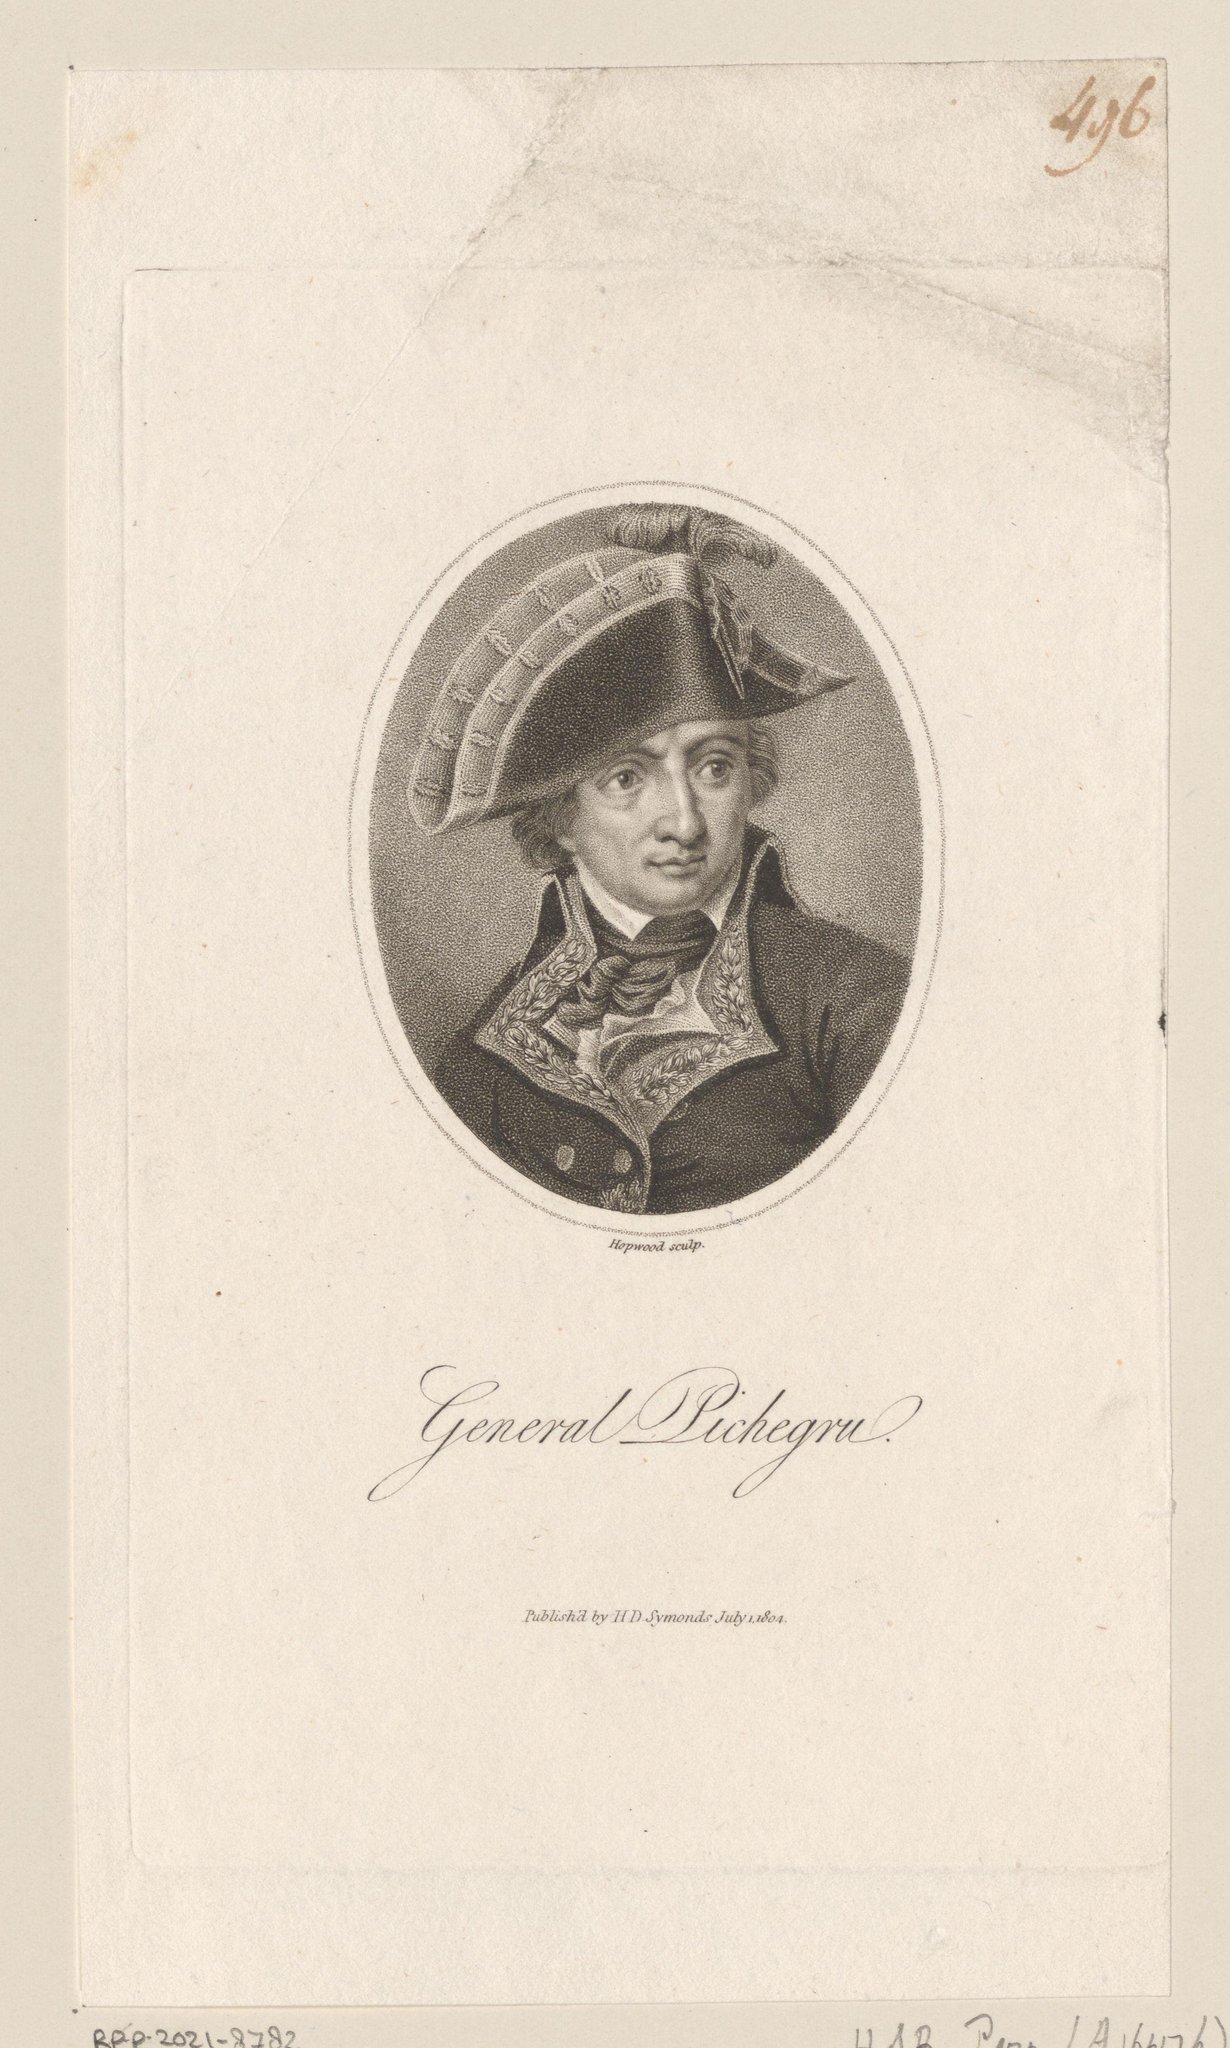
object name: print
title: Portret van Jean-Charles Pichegru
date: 1804-1807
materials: paper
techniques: engraving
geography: london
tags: paris, politician, jean-charles pichegru, commander-in-chief, general, marshal, historical persons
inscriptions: inscription: ‘496’